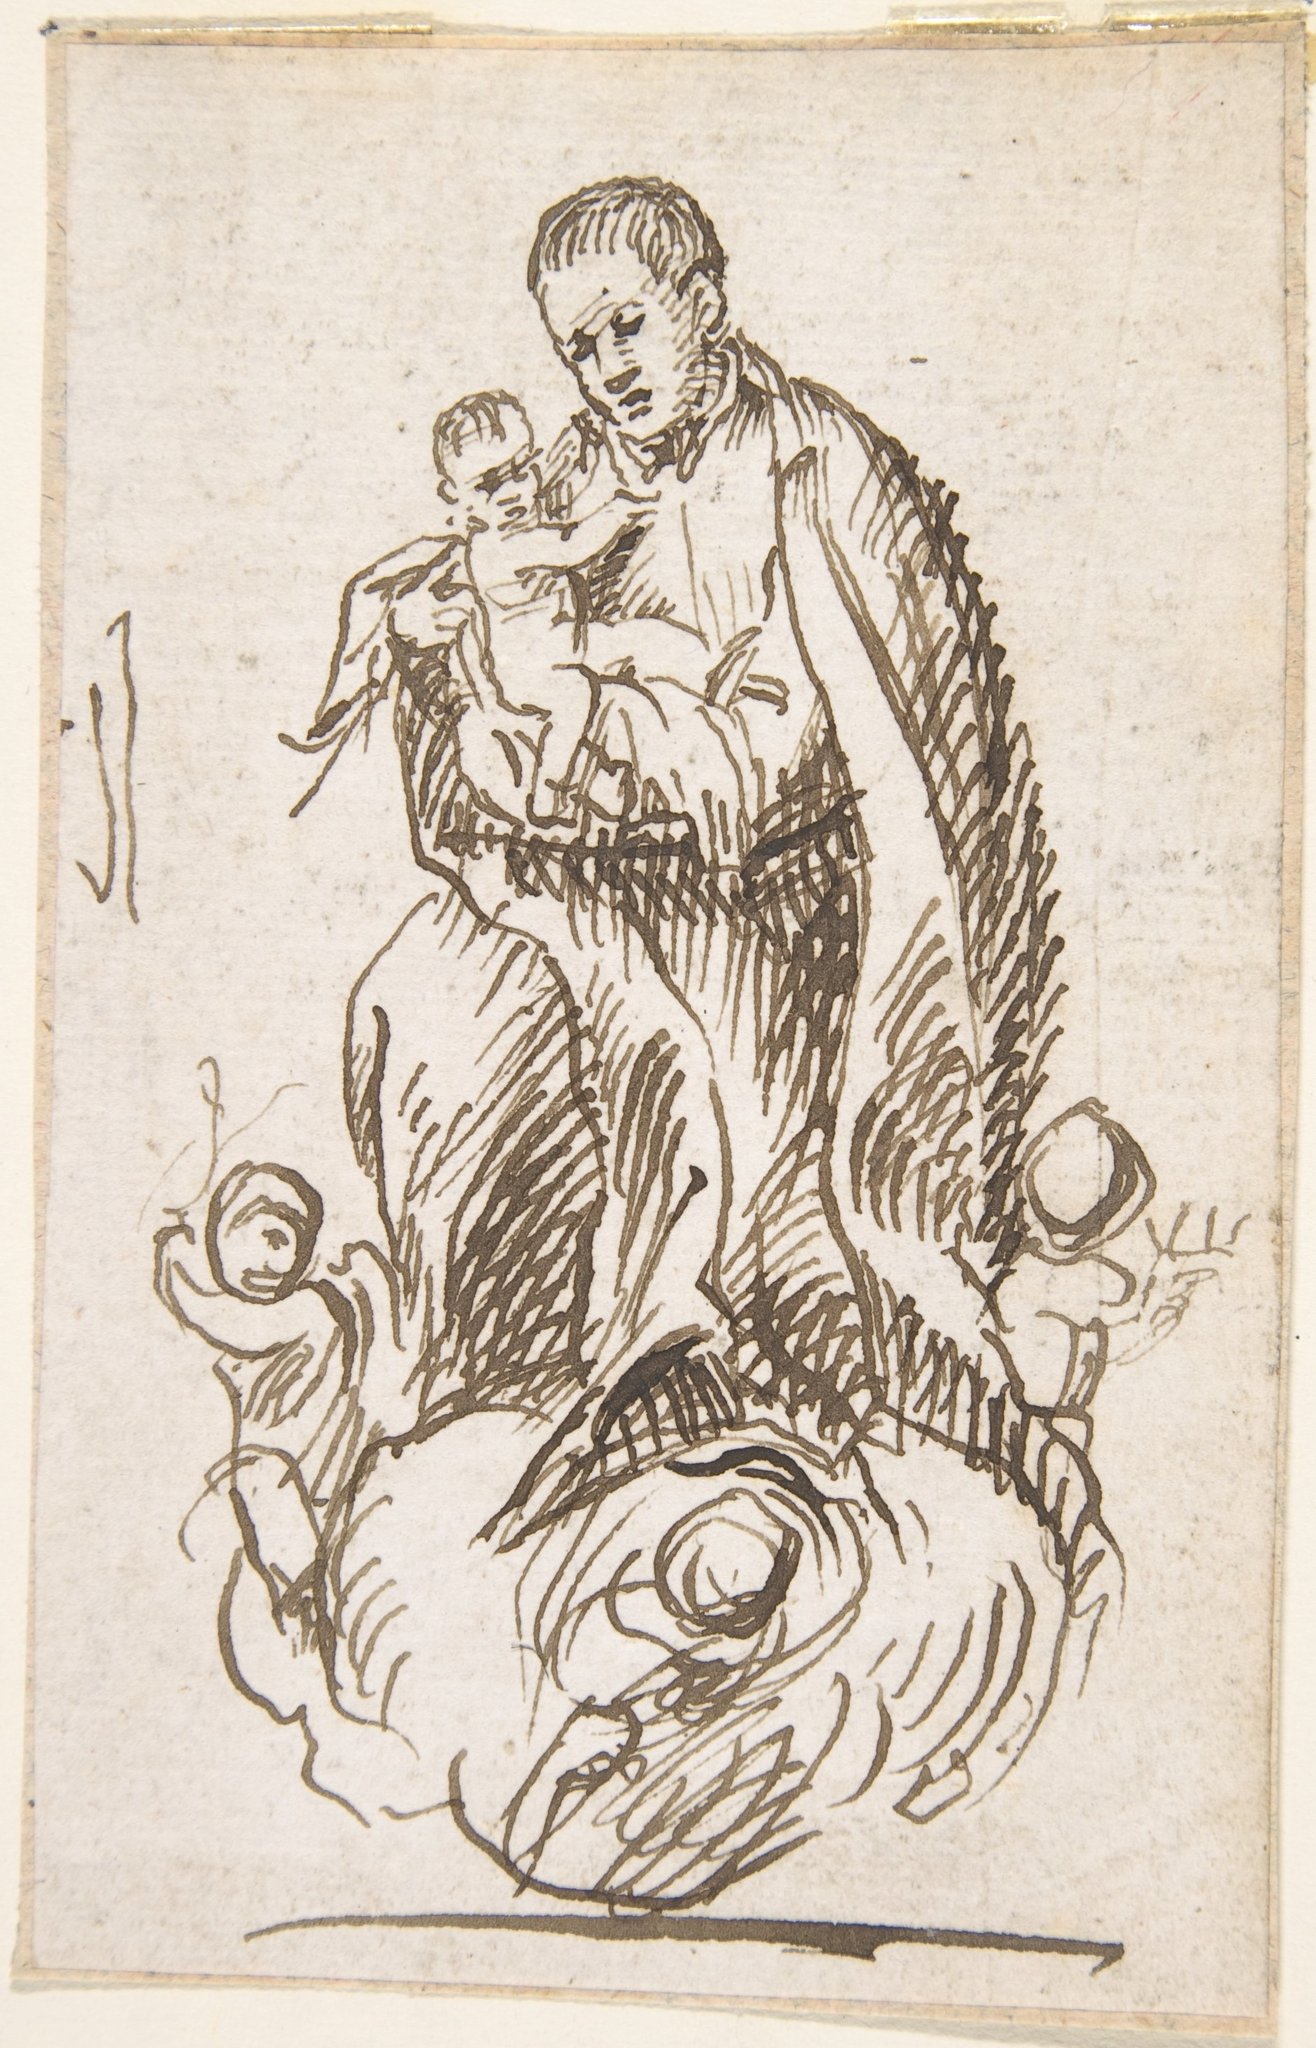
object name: drawing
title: Male Saint (Stanisław Kostka?) standing on clouds supported by putti, holding infant Christ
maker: pedro duque cornejo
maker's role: artist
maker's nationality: spanish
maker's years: 1677-1757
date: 1731-1733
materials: ink, paper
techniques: pen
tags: infants,cupid,christ,saints